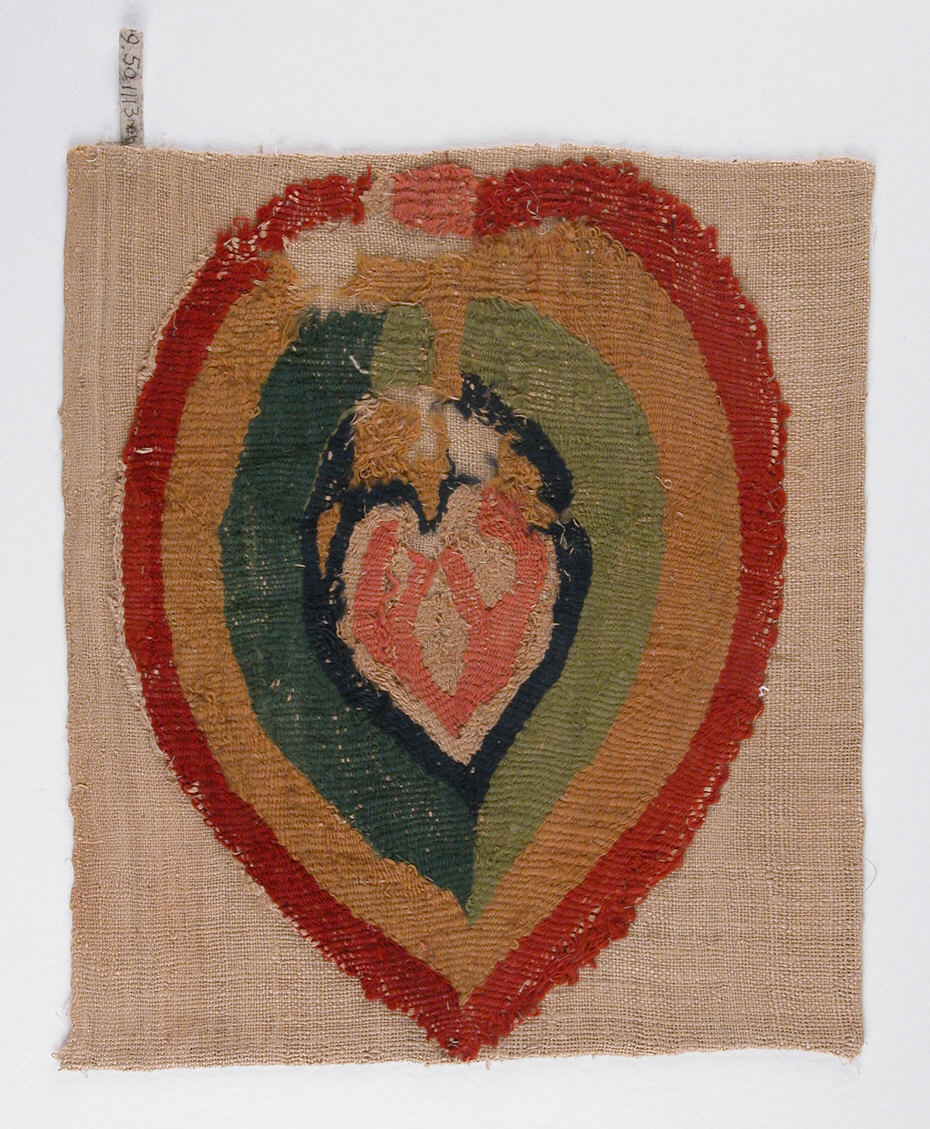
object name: ornament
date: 501-700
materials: linen, wool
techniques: weave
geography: egypt